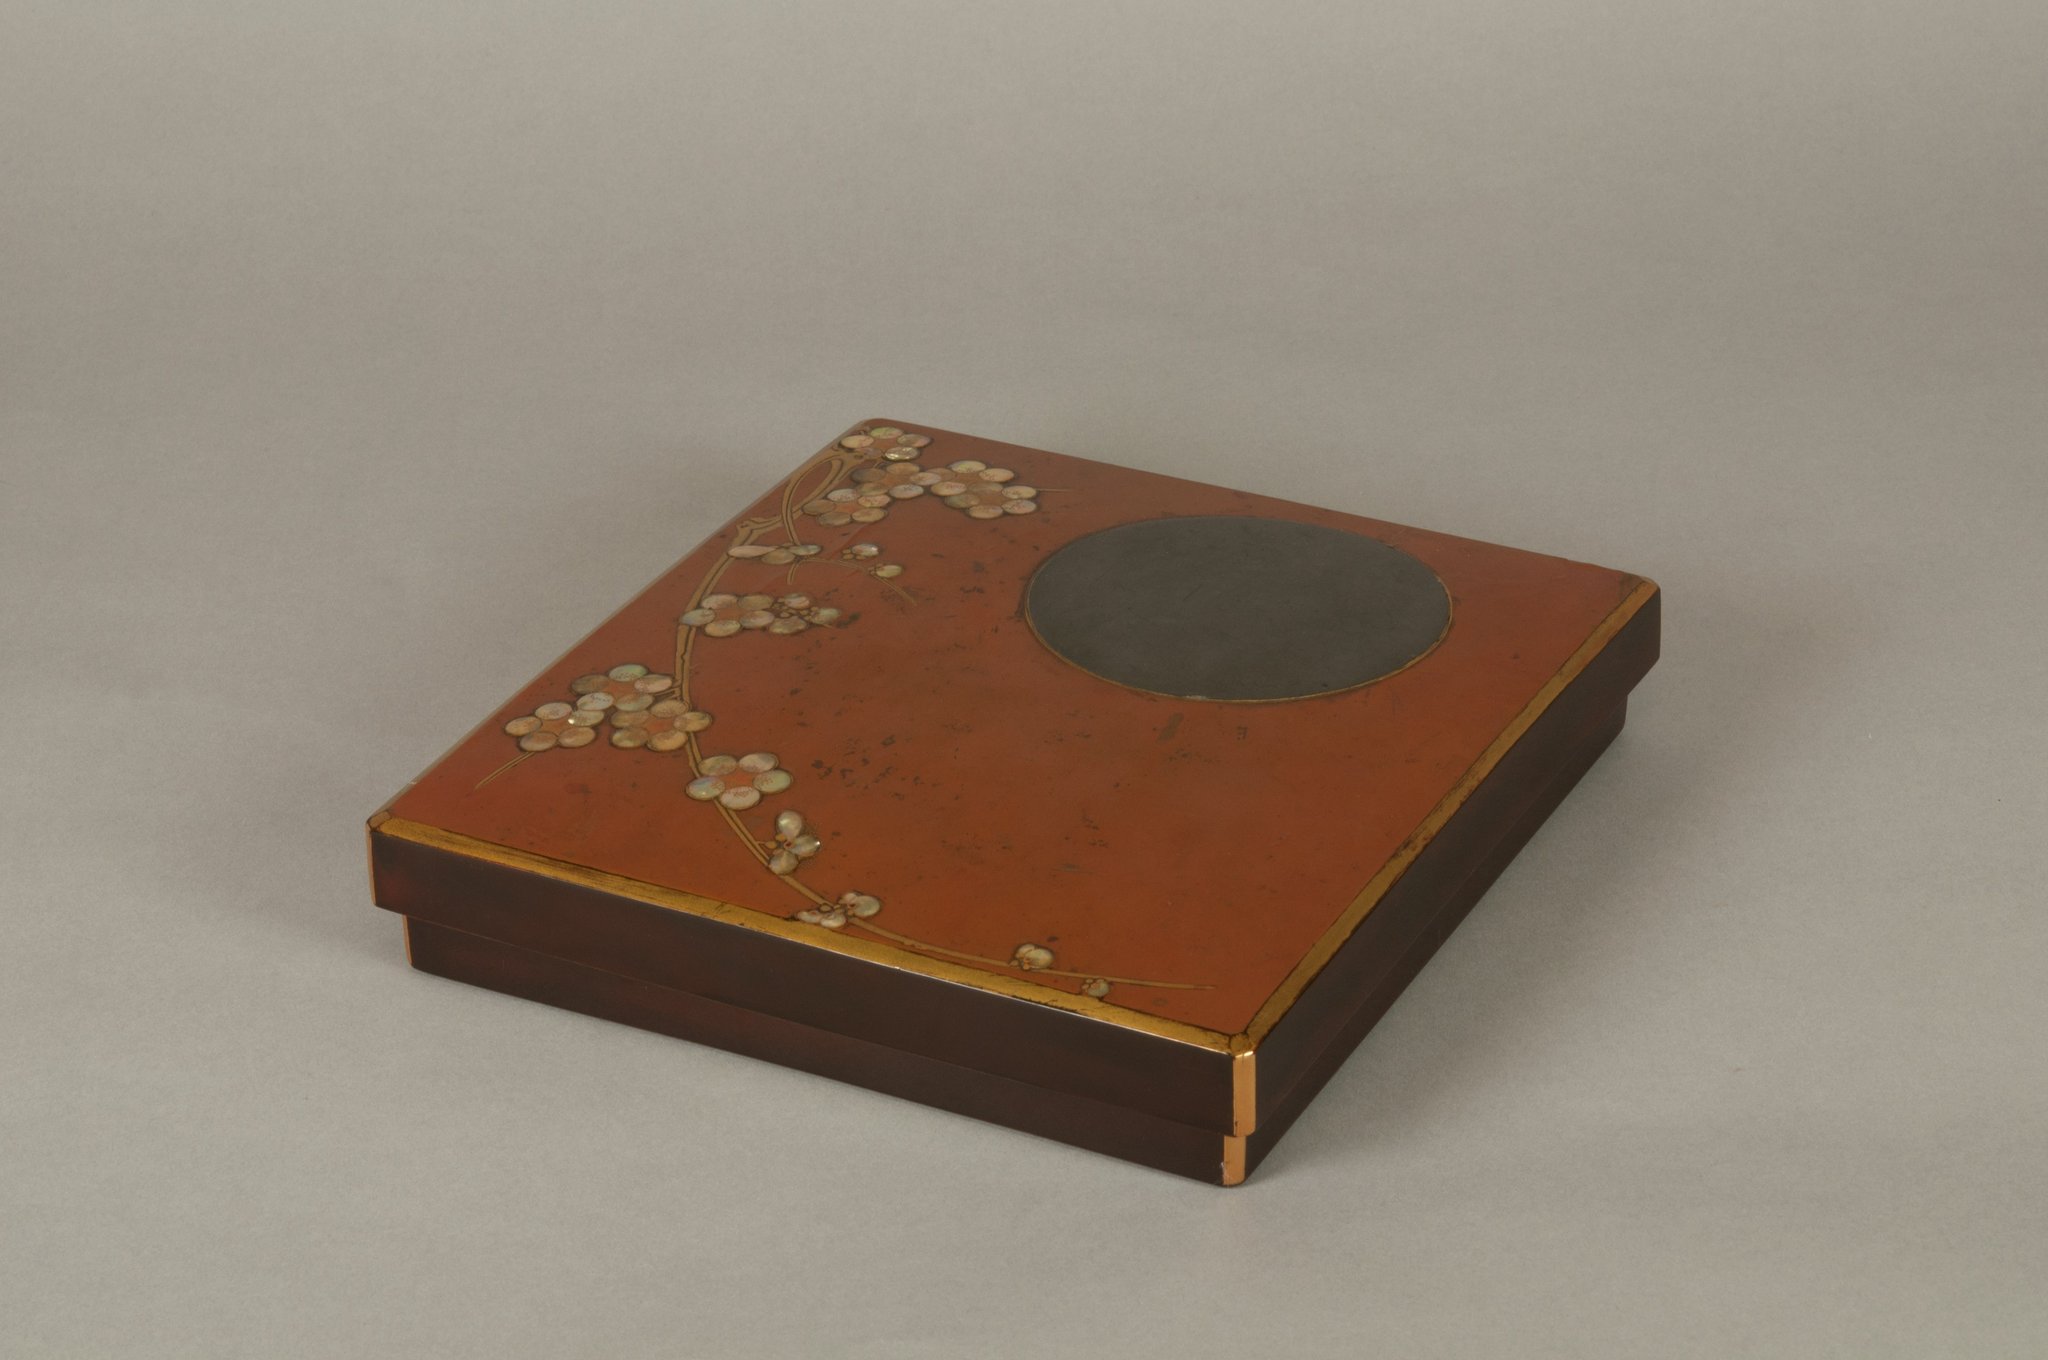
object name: writing box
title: Writing Box with Design of Plum Blossoms and Moon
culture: japanese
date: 1701-1800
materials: gold, lacquer, lead, mother of pearl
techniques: hiramakie, inlay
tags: moon,flowers